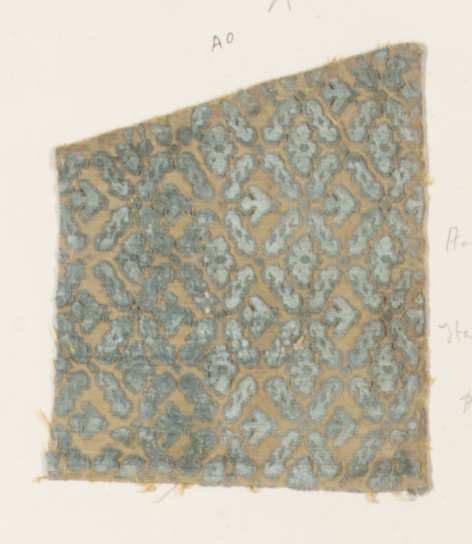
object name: fragment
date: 1501-1600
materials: silk